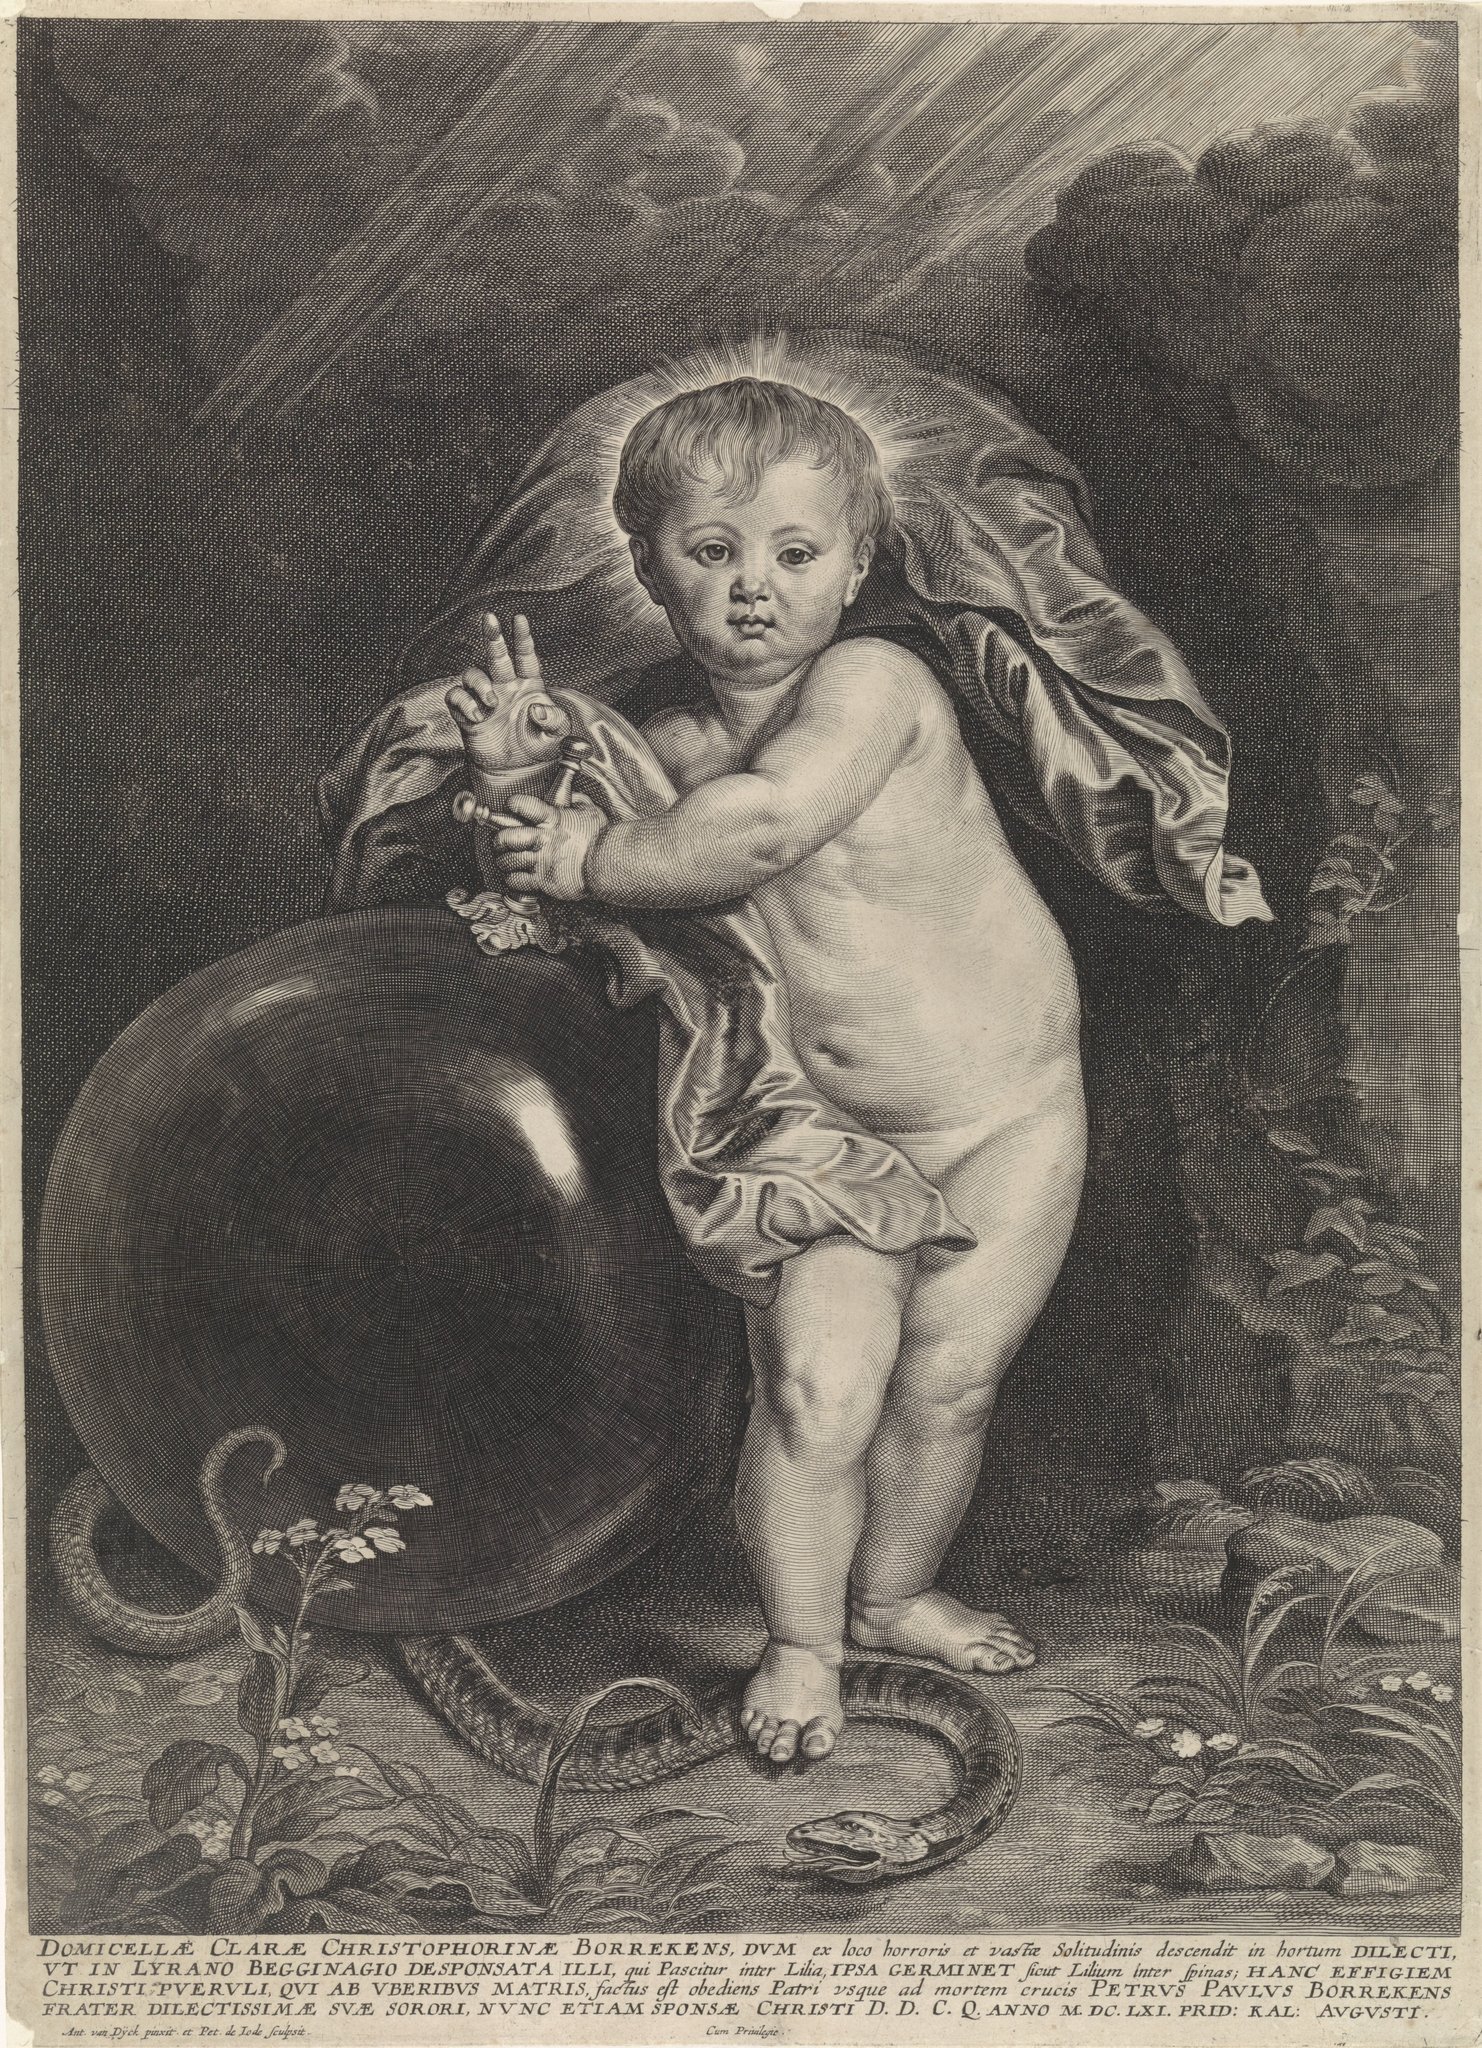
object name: print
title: Christuskind met rijksappel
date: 1628-1670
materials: paper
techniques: engraving, etching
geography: england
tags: snakes, christ-child (with attributes)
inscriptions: collector's mark: Lugt 240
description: Het Christuskind, leunend op een rijksappel. Hij vertrapt de slang met zijn rechtervoet. In de marge een vierregelig onderschrift in het Latijn.